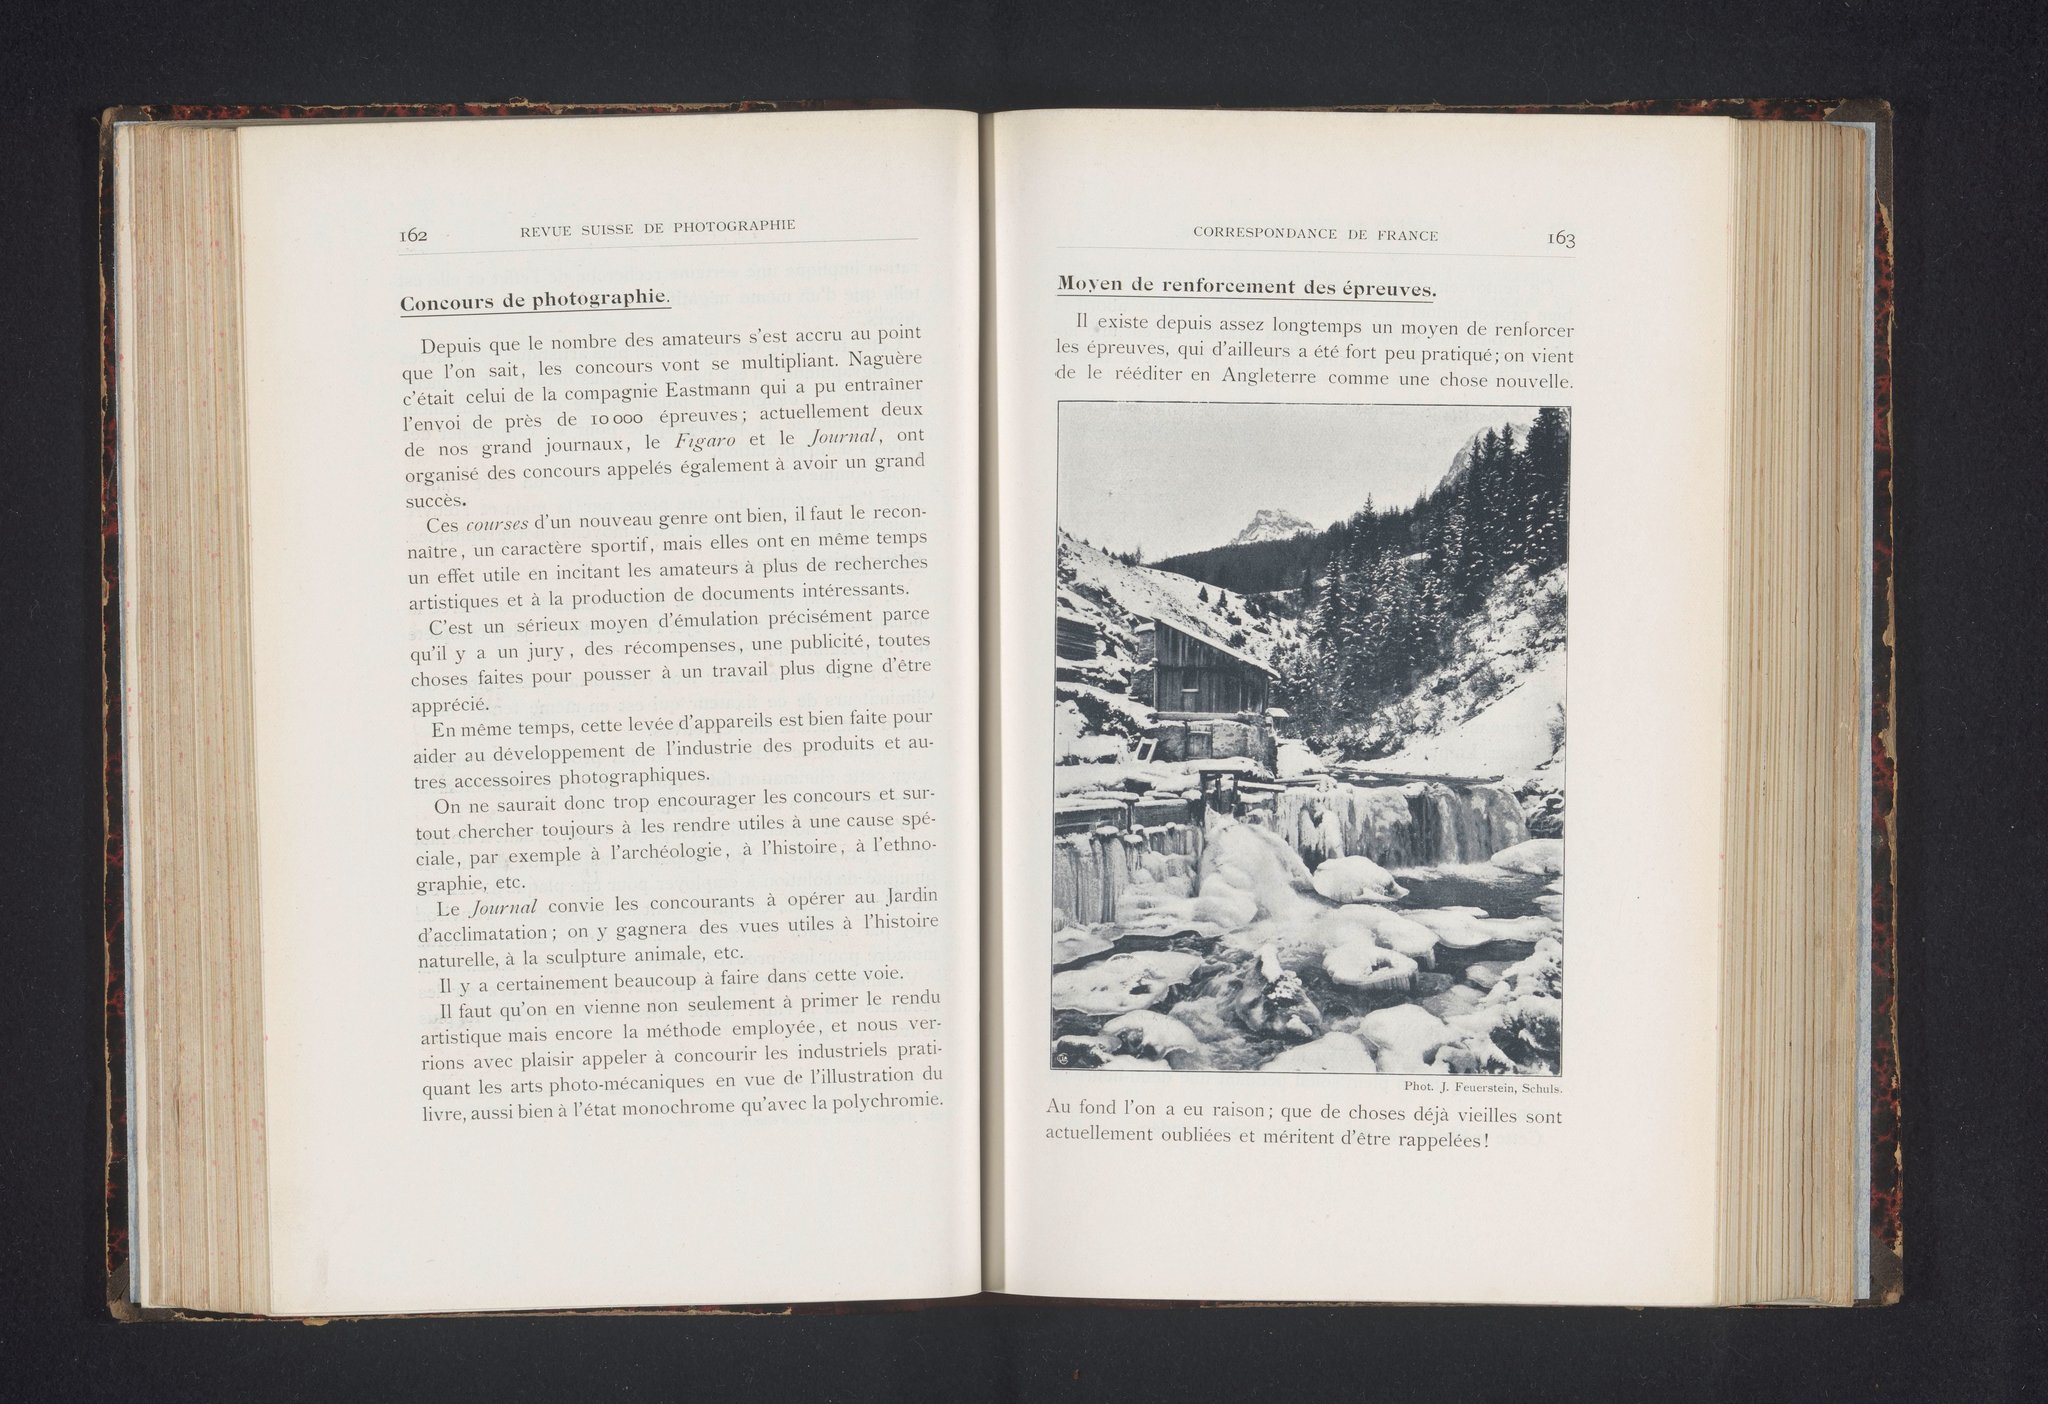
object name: page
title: Berglandschap in de sneeuw met een hut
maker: j. feuerstein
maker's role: fotograaf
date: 1897-1902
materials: paper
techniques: autotype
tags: snow, mountain-range, snow peaks, hut, cabin, lodge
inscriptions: inscription: ‘Revue Suisse de photographie’, monogram: ‘C. Cie’